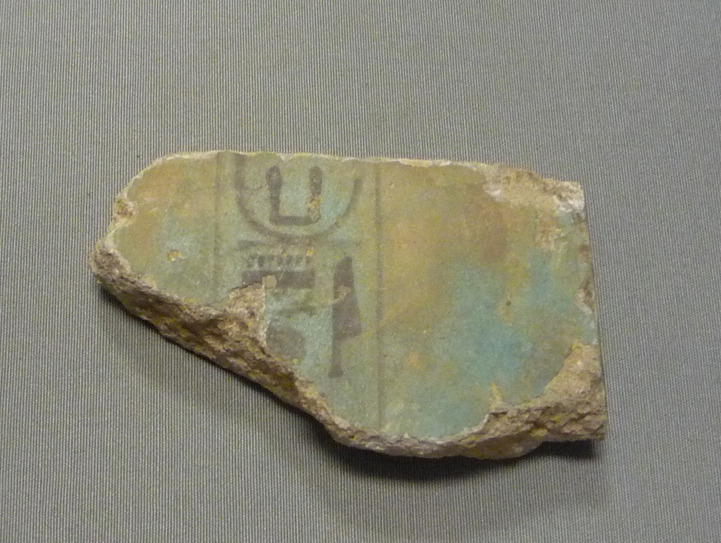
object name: foundation deposit plaque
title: Inscribed Plaque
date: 1479-1458 BCE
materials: faience, paint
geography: egypt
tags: hieroglyphs